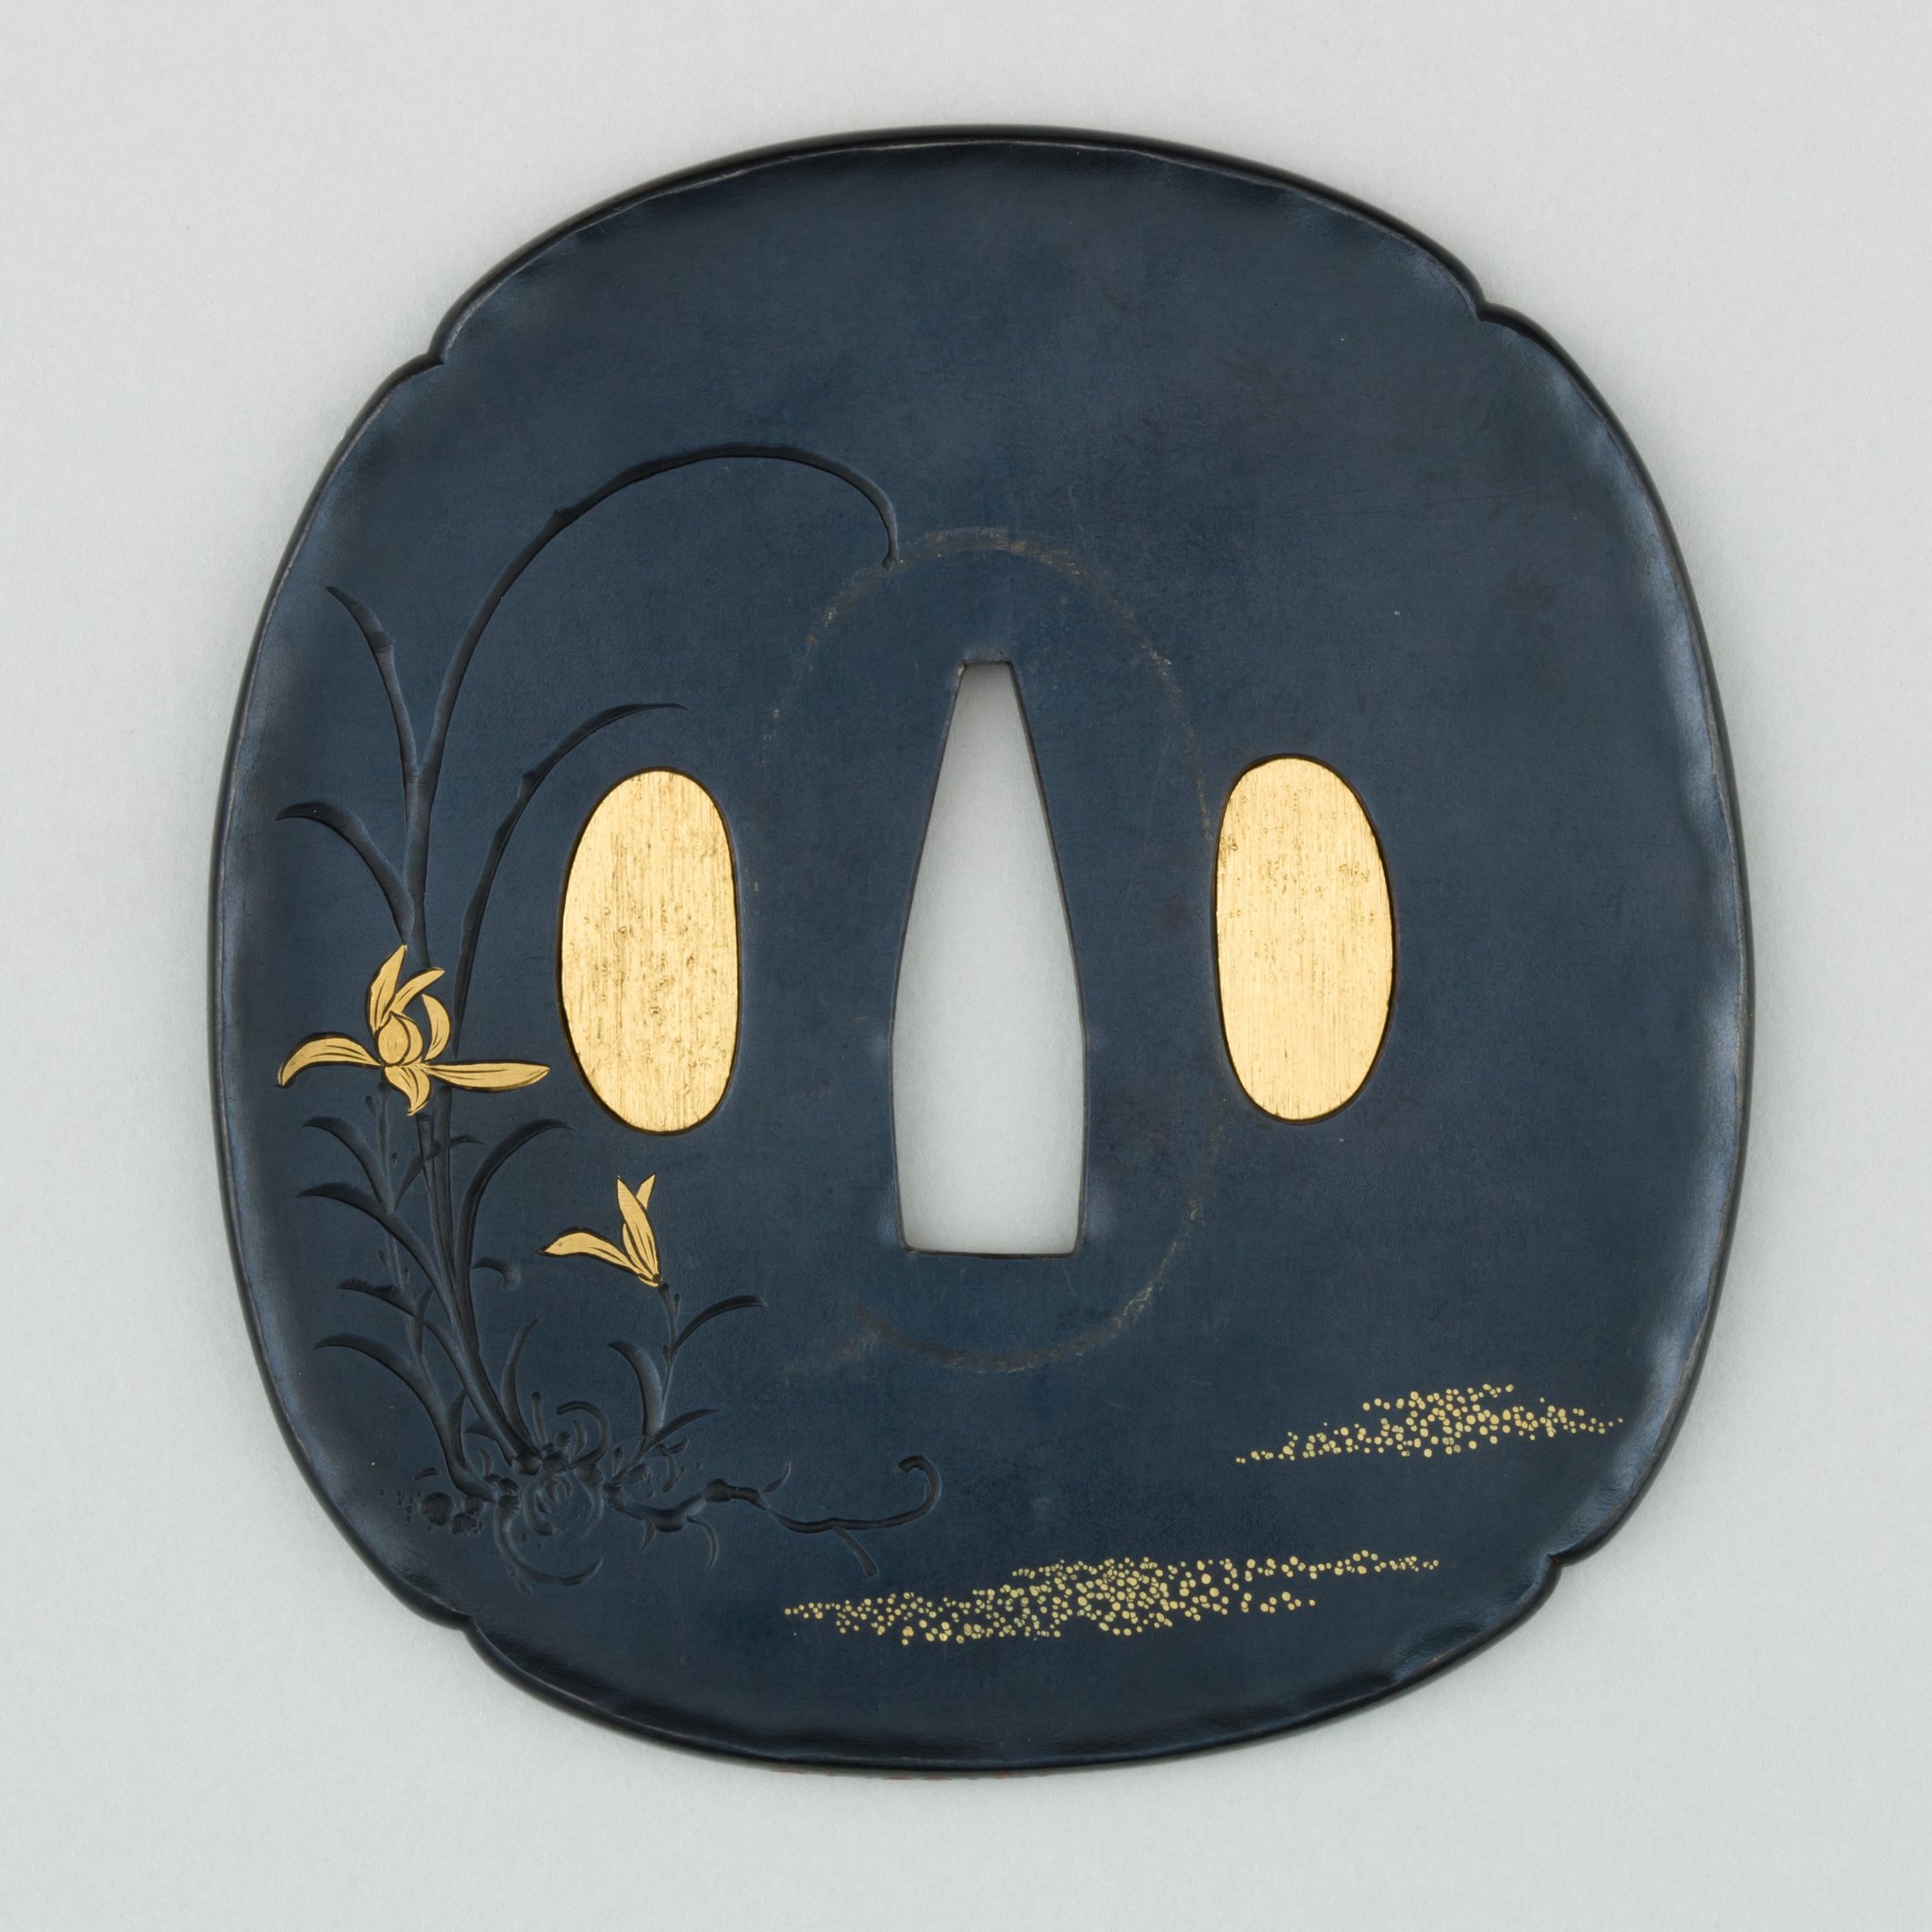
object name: sword guard tsuba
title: Sword Guard (Tsuba)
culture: japanese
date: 1701-1800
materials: copper, gold alloy, gold, silver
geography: japan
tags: flowers